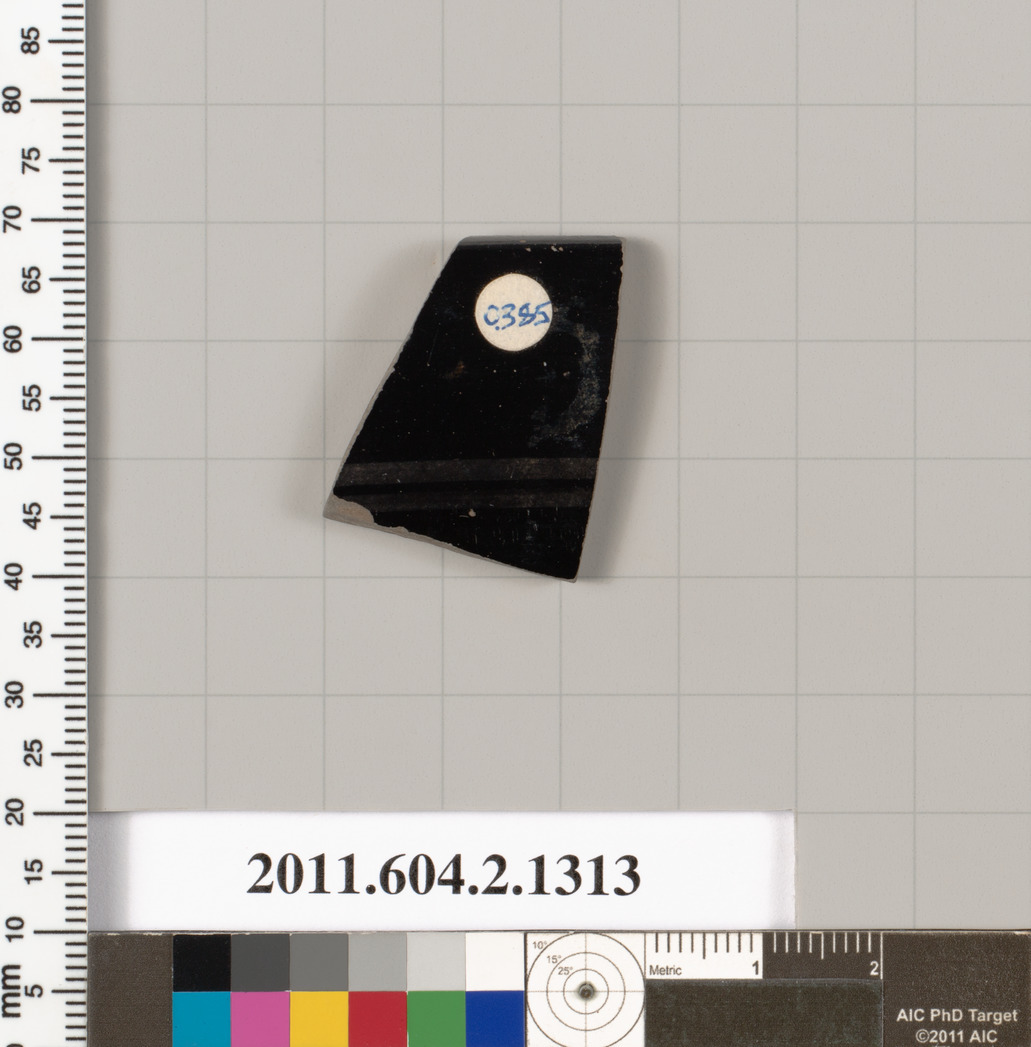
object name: skyphos fragment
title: Terracotta rim fragment of a skyphos (deep drinking cup)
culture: greek, attic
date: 401-425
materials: terracotta